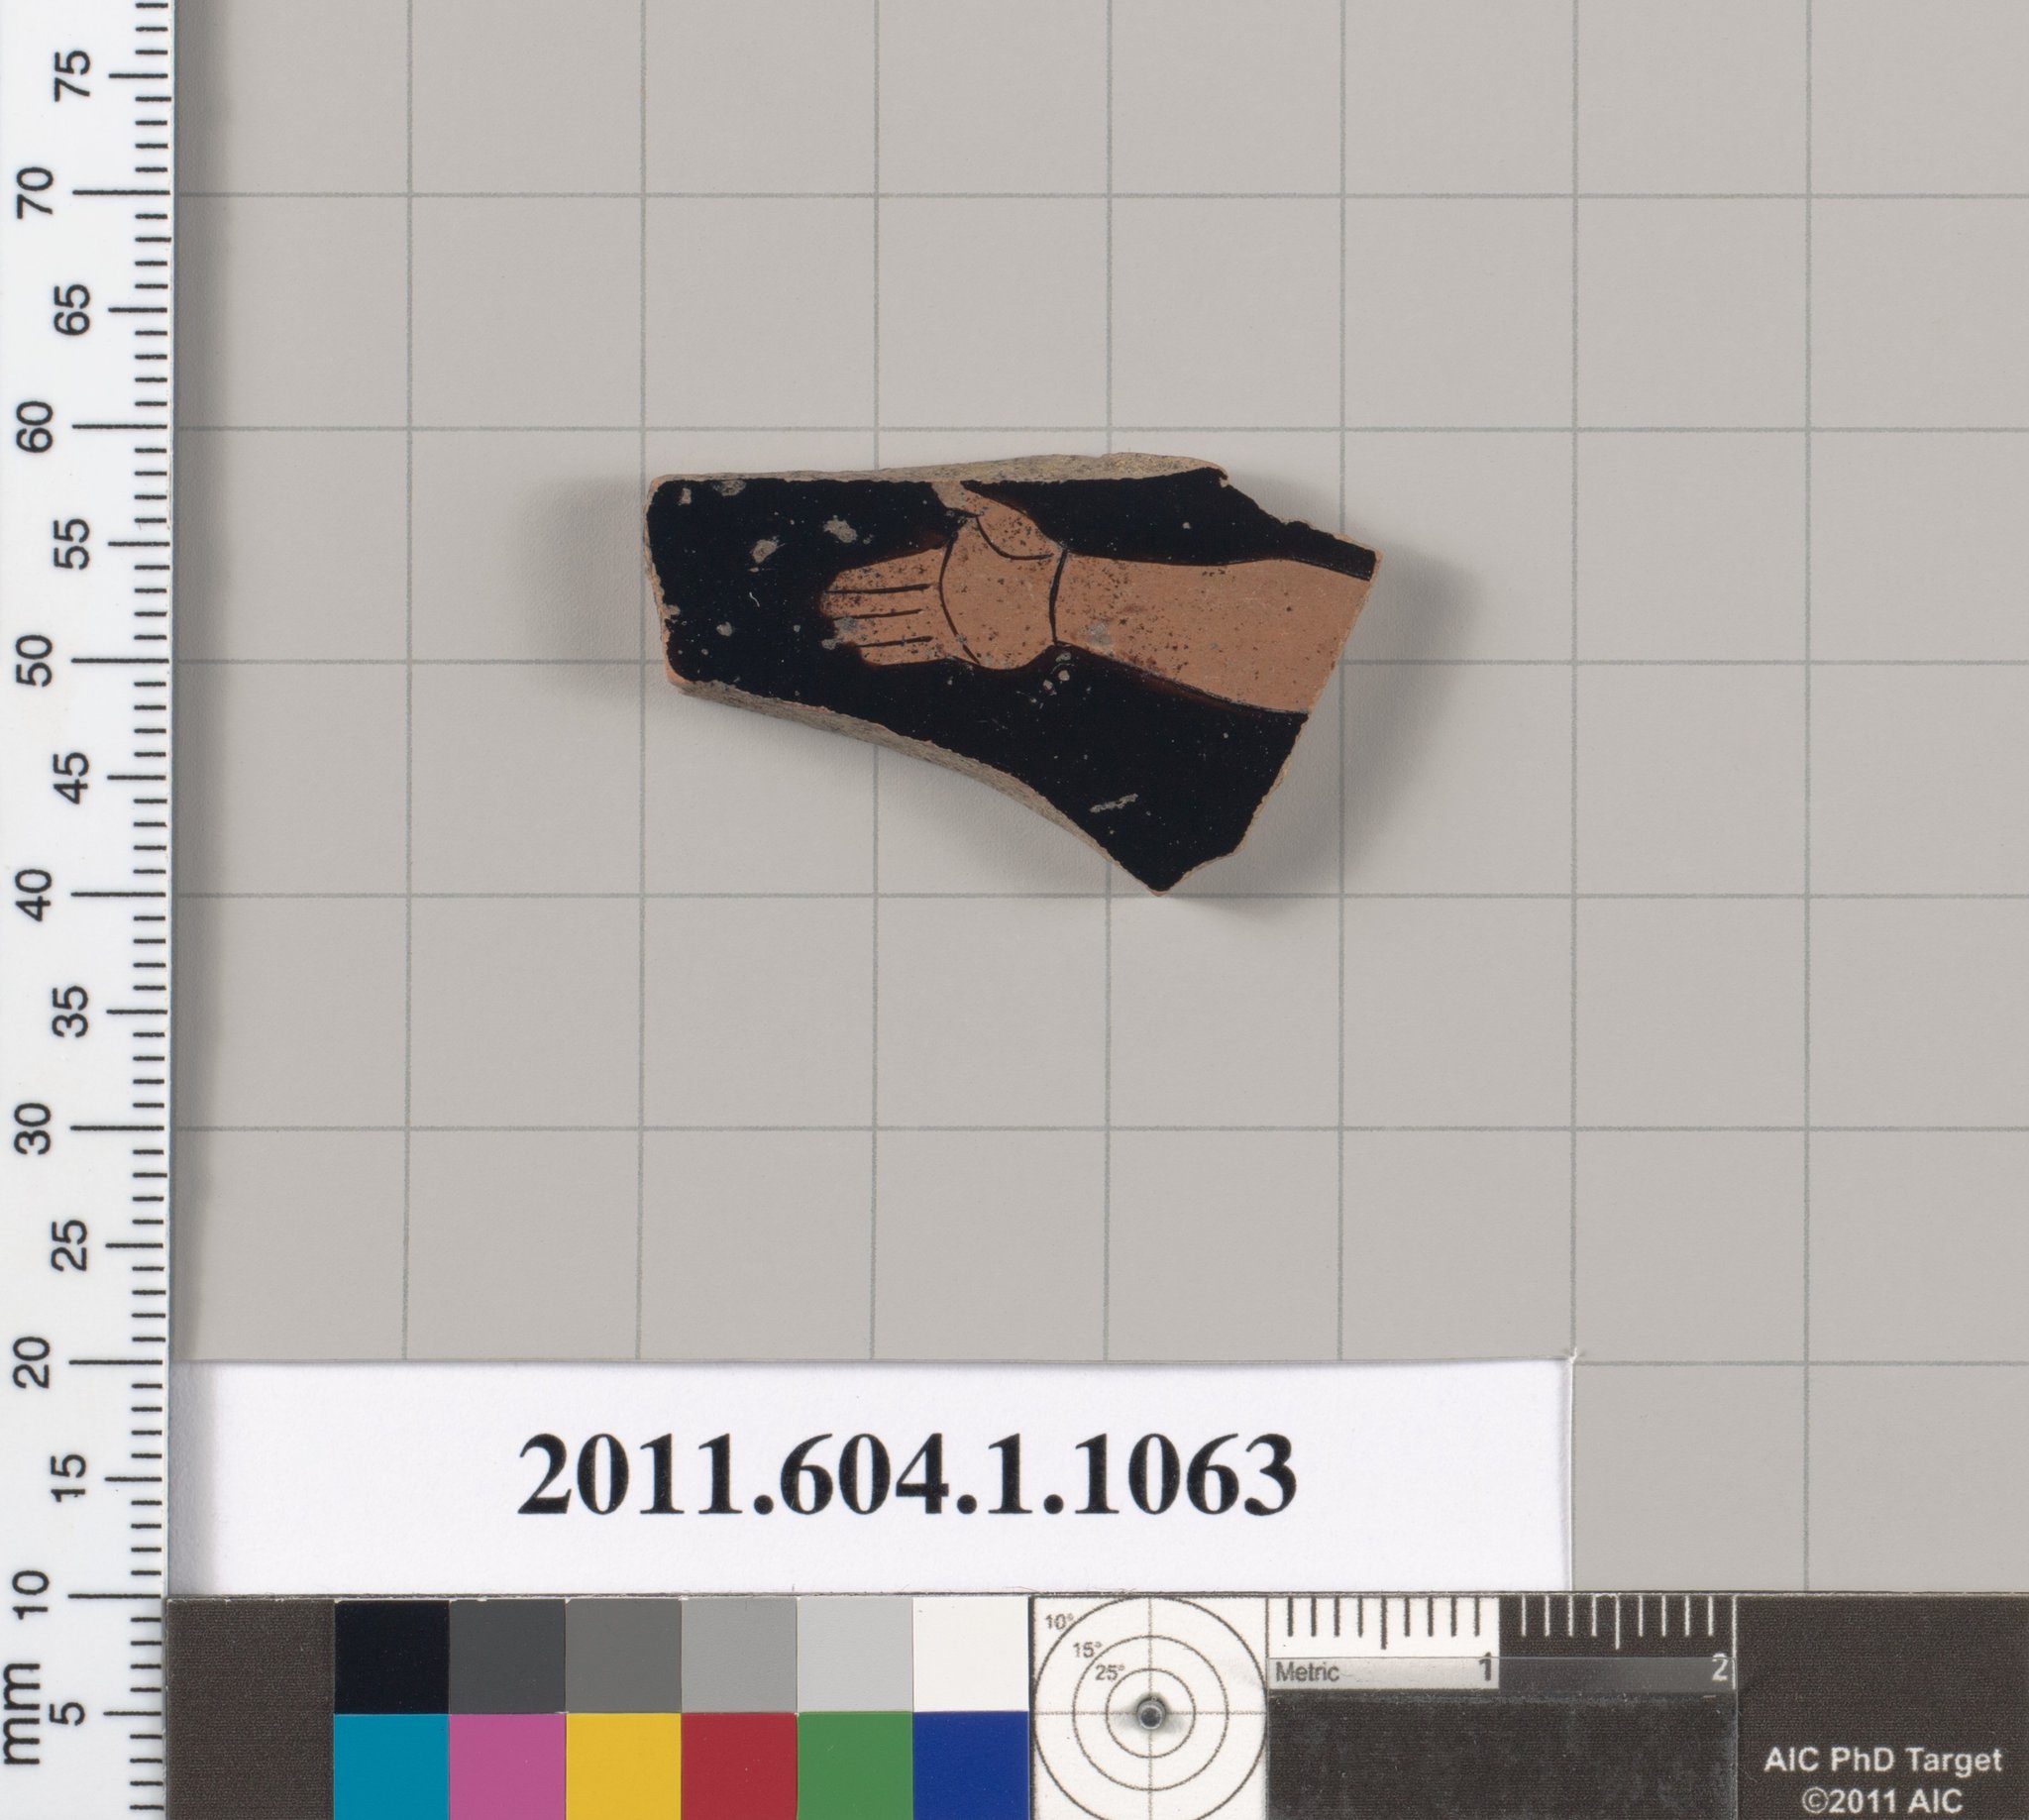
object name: kylix fragment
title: Terracotta fragment of a kylix (drinking cup)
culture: greek, attic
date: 475-451 BCE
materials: terracotta